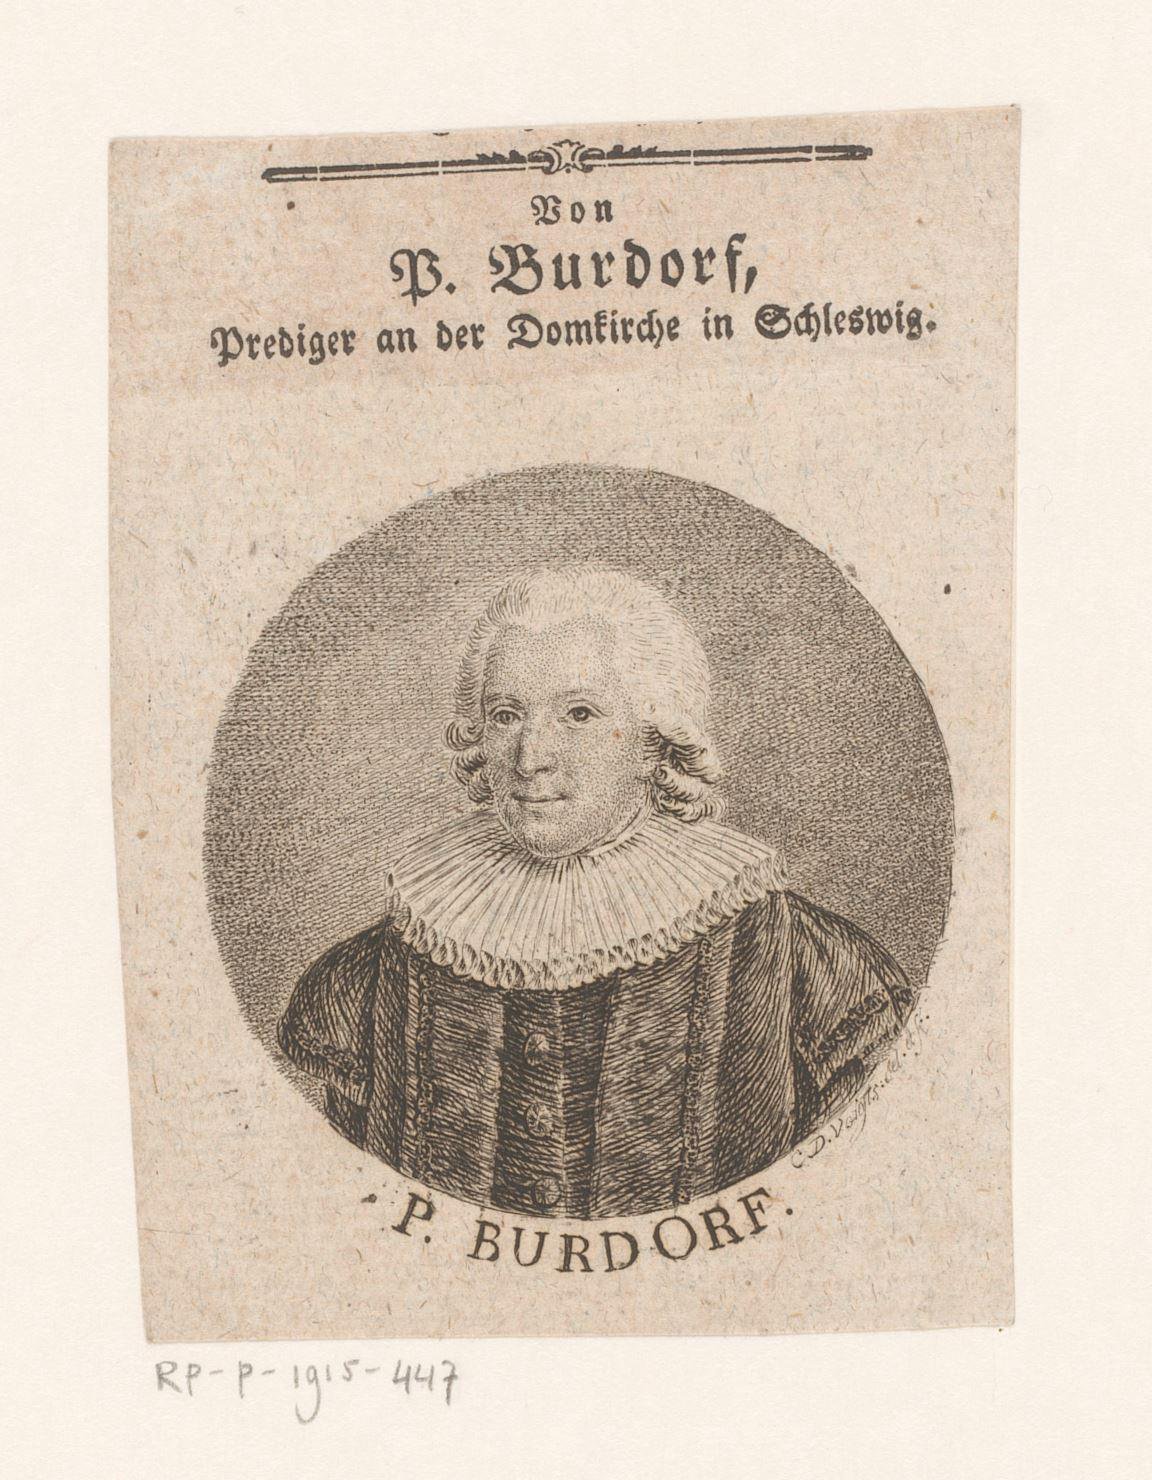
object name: print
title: Titelpagina voor: Peter Burdorf, Predigten über die Evangelien an den Sonn- und Festtagen des ganzen Jahres, 1793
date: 1793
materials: paper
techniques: etching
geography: germany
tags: historical persons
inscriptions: collector's mark: Lugt 2228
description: Titelpagina voor de publicatie: Burdorf, Peter. Predigten über die Evangelien an den Sonn- und Festtagen des ganzen Jahres. Sleeswijk: R.J. Boie, 1793.